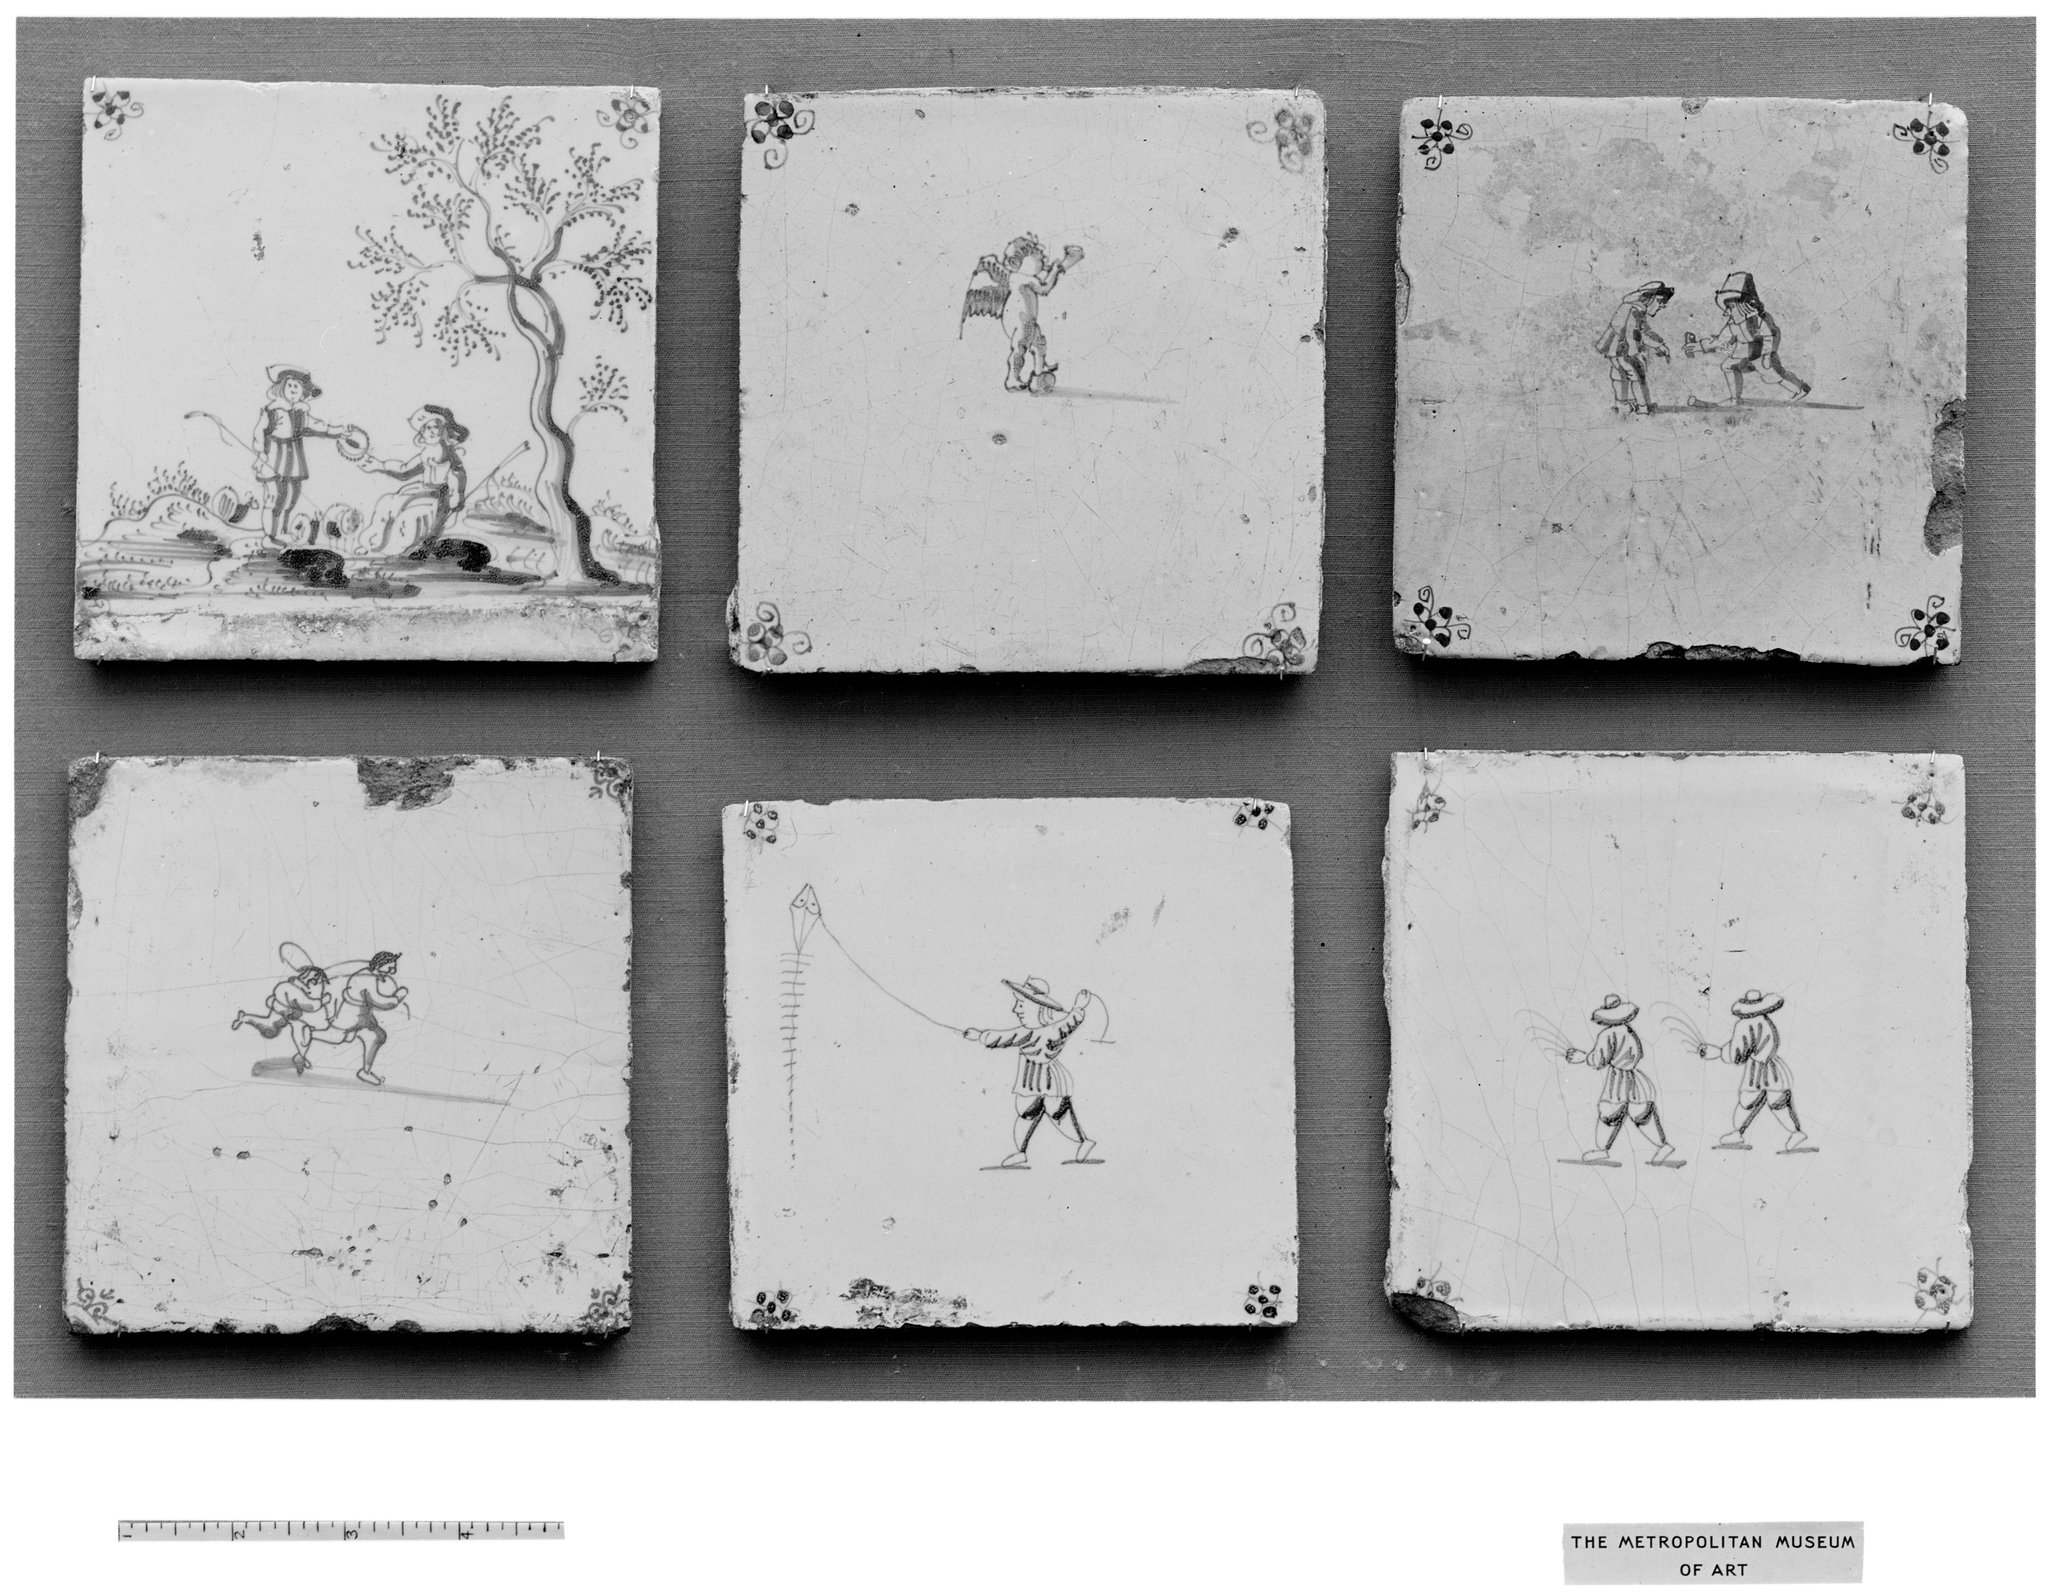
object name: tile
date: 1701-1800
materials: earthenware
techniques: glazing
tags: boys,men,women